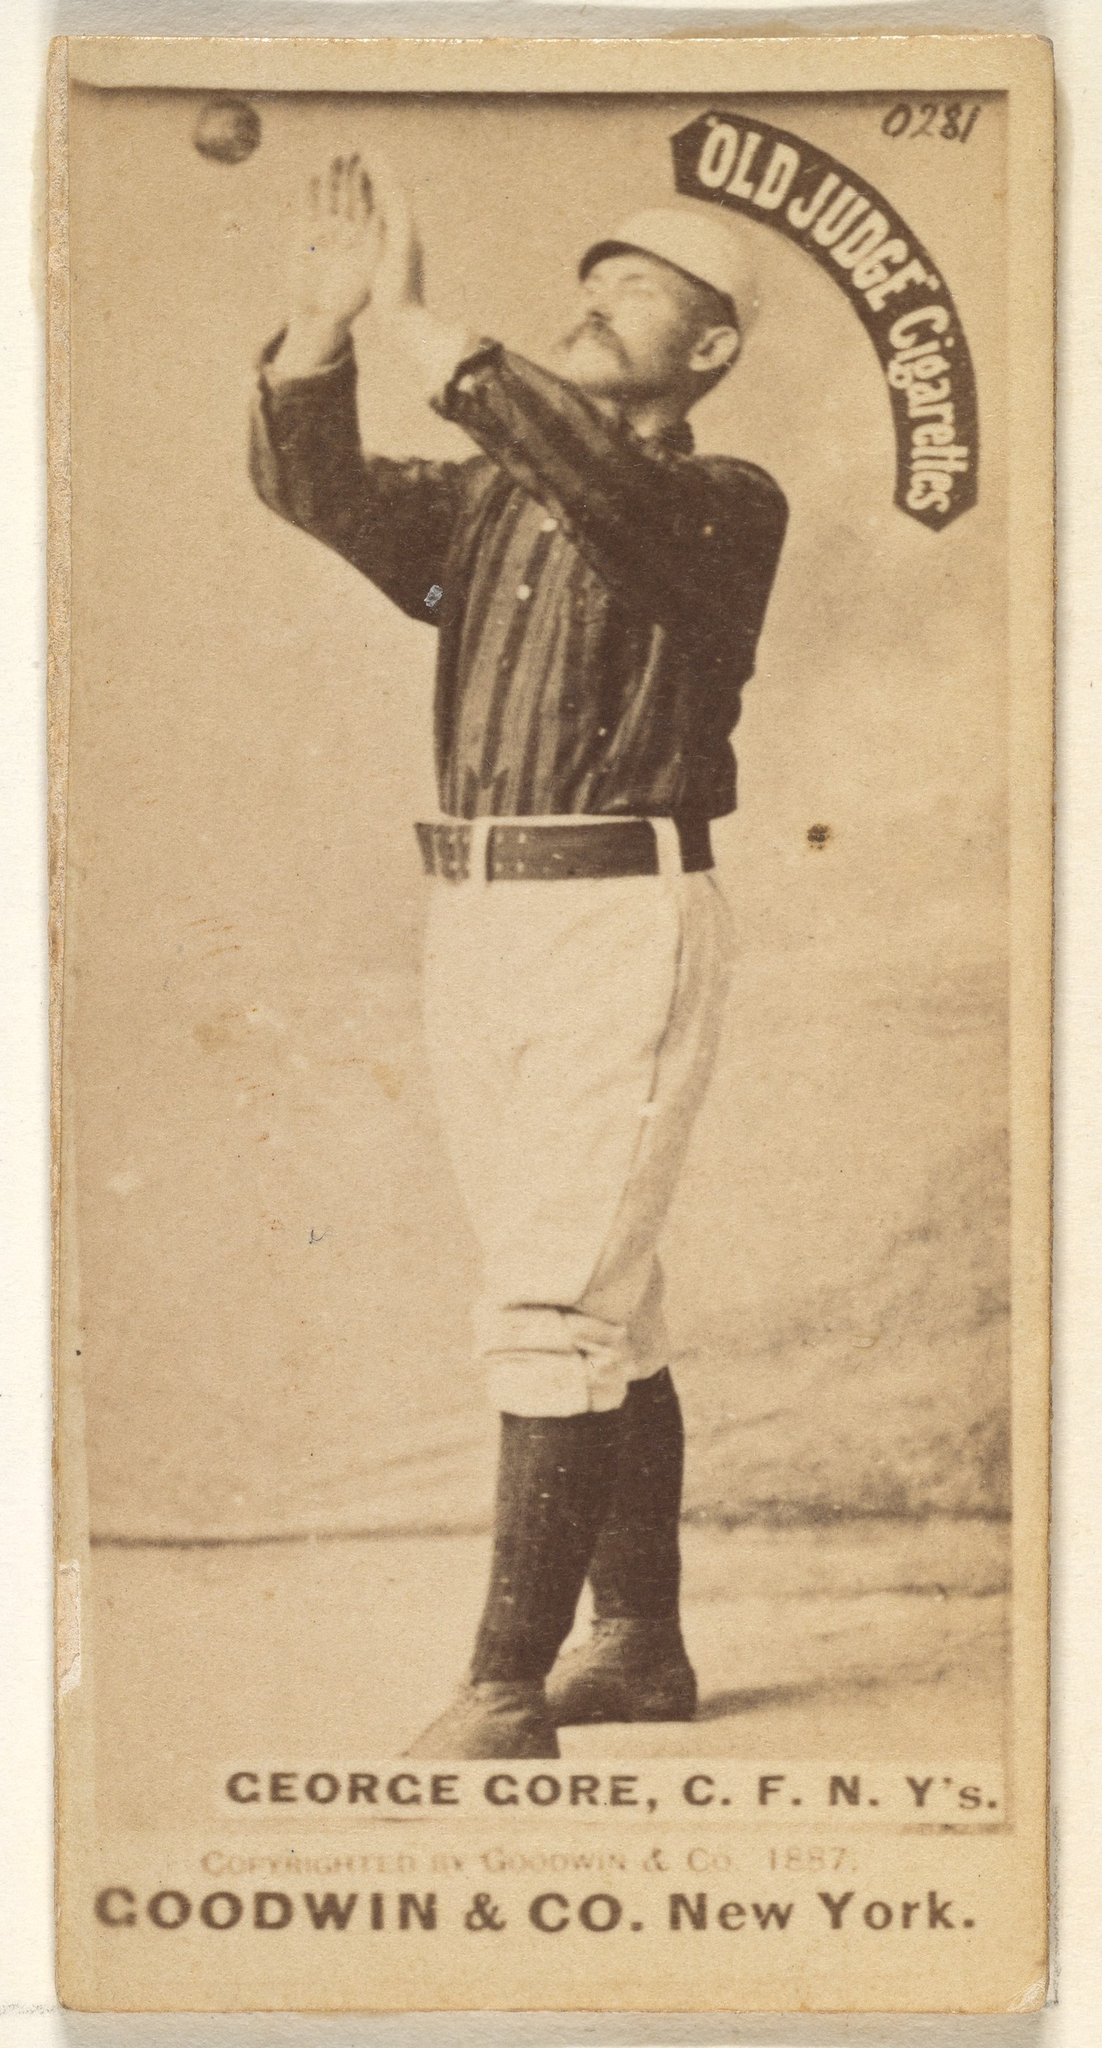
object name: baseball card, photograph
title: George F. "Piano Legs" Gore, Center Field, New York, from the Old Judge series (N172) for Old Judge Cigarettes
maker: goodwin & company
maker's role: publisher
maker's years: 1850-1950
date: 1887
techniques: albumen silver print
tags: men,portraits,baseball,athletes